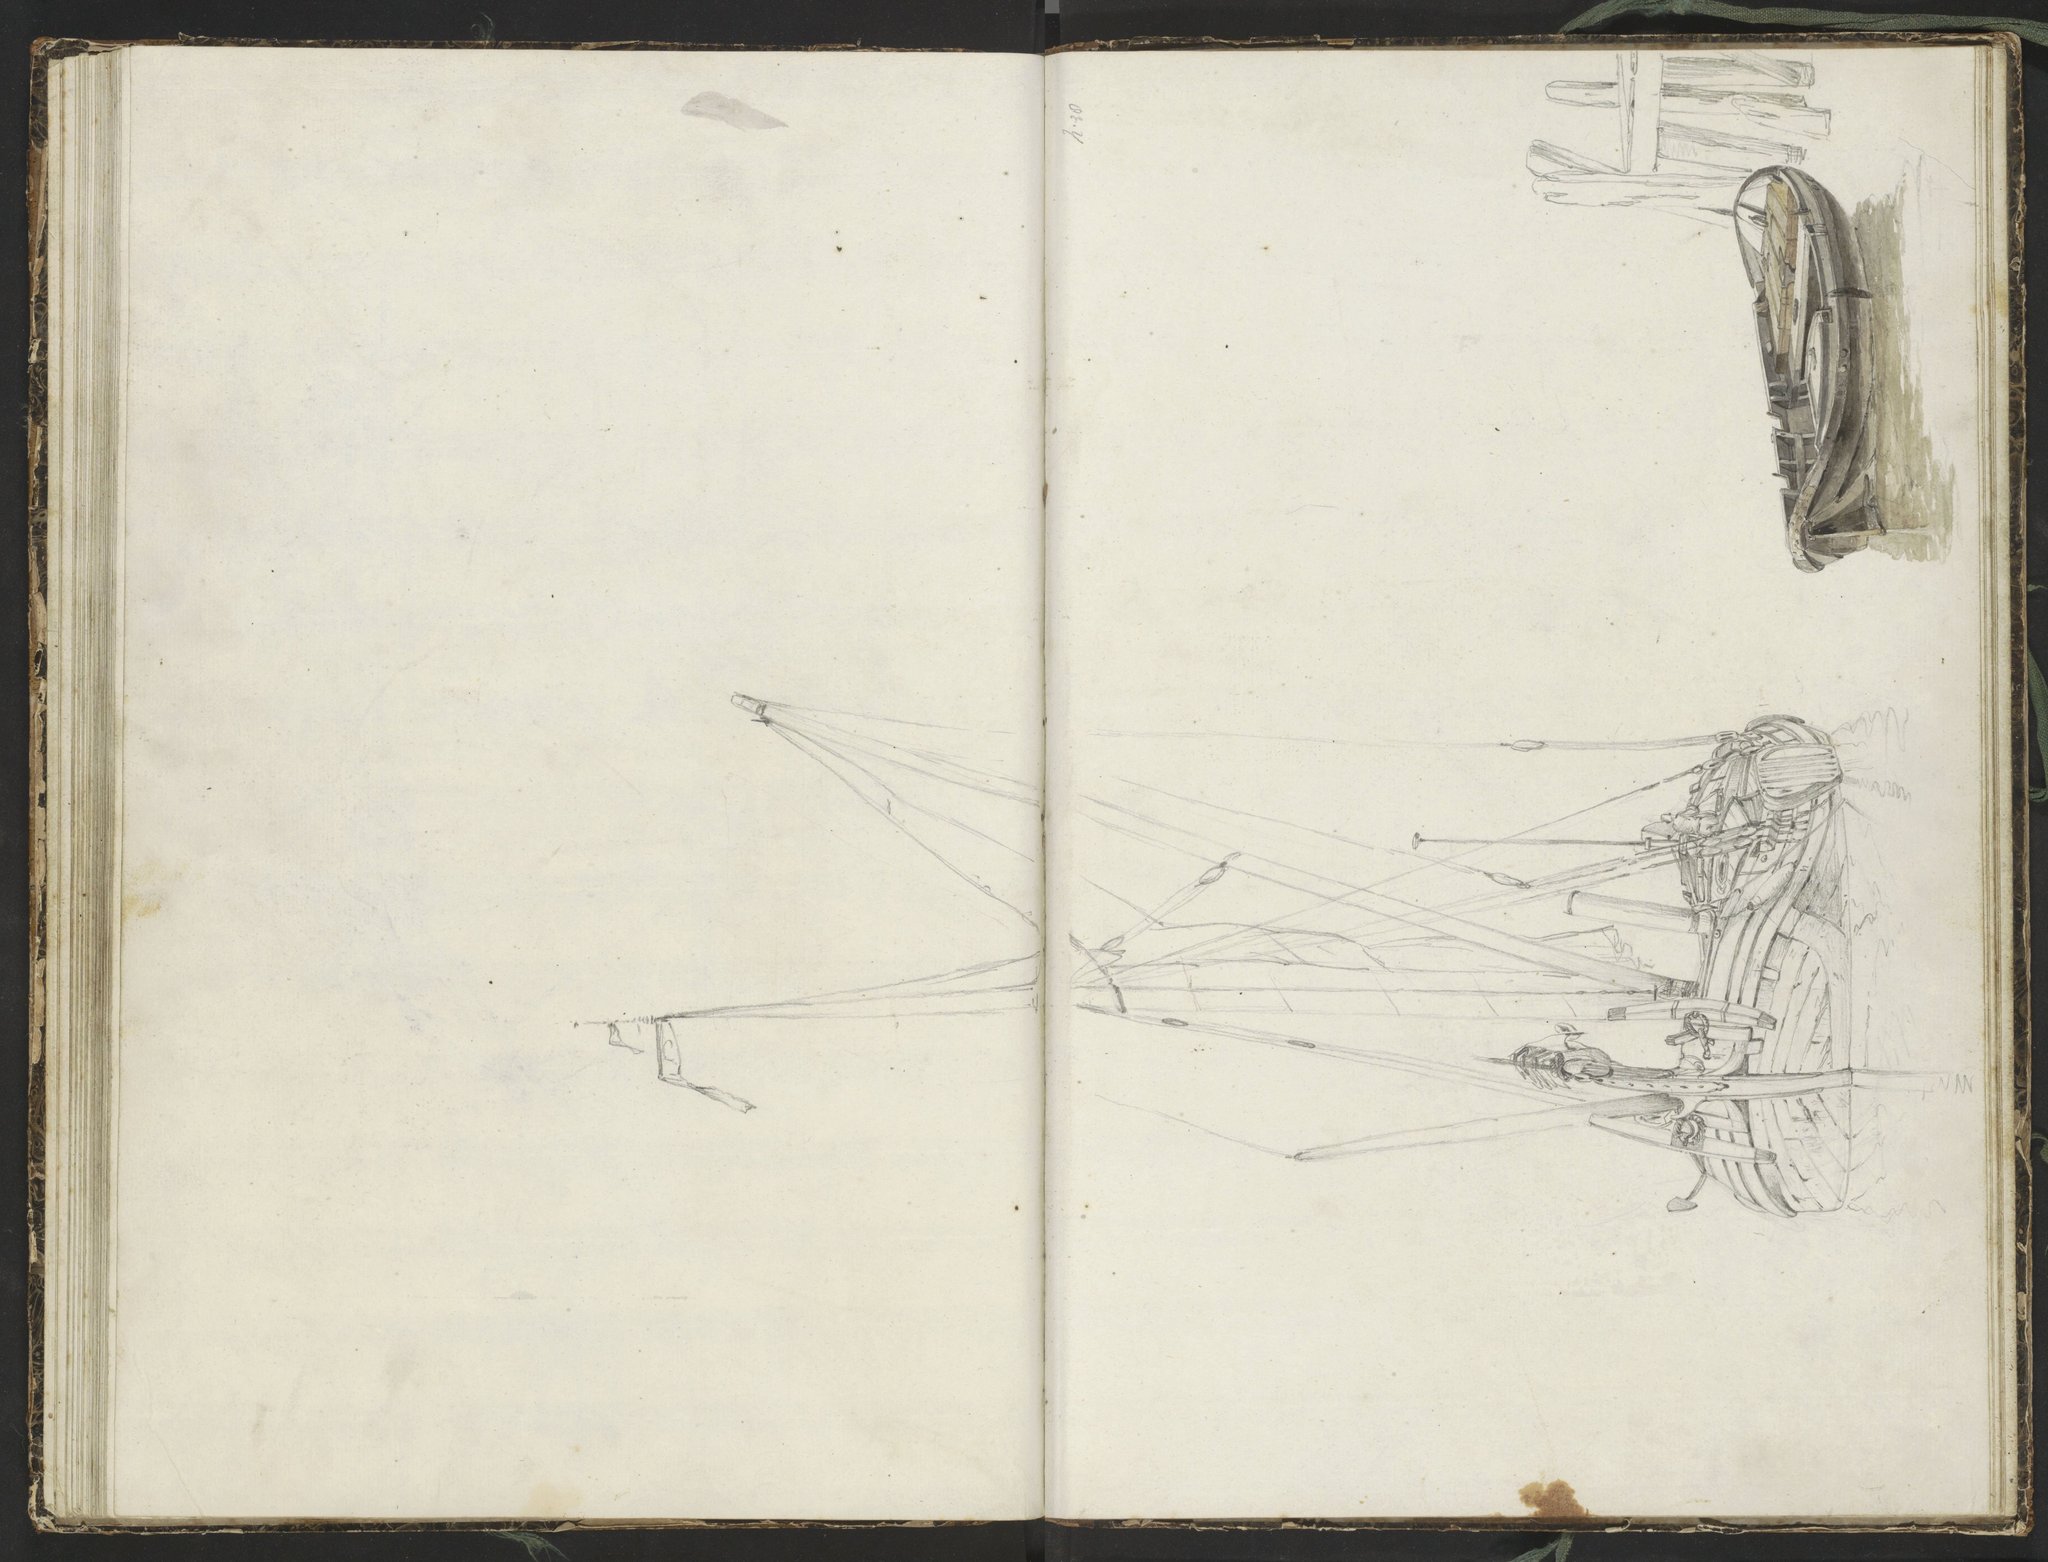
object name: sketchbook leaf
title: Man op een vissersboot en een sloep bij een aanlegplaats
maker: johannes christiaan schotel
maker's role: draughtsman, painter, print maker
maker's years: 1787-1838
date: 1797-1838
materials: paper, pencil, watercolor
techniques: brush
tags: sailing-ship, sailing-boat, rowing-boat, canoe, etc.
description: Blad 36 verso en 36-1 recto uit een schetsboek met 44 bladen.